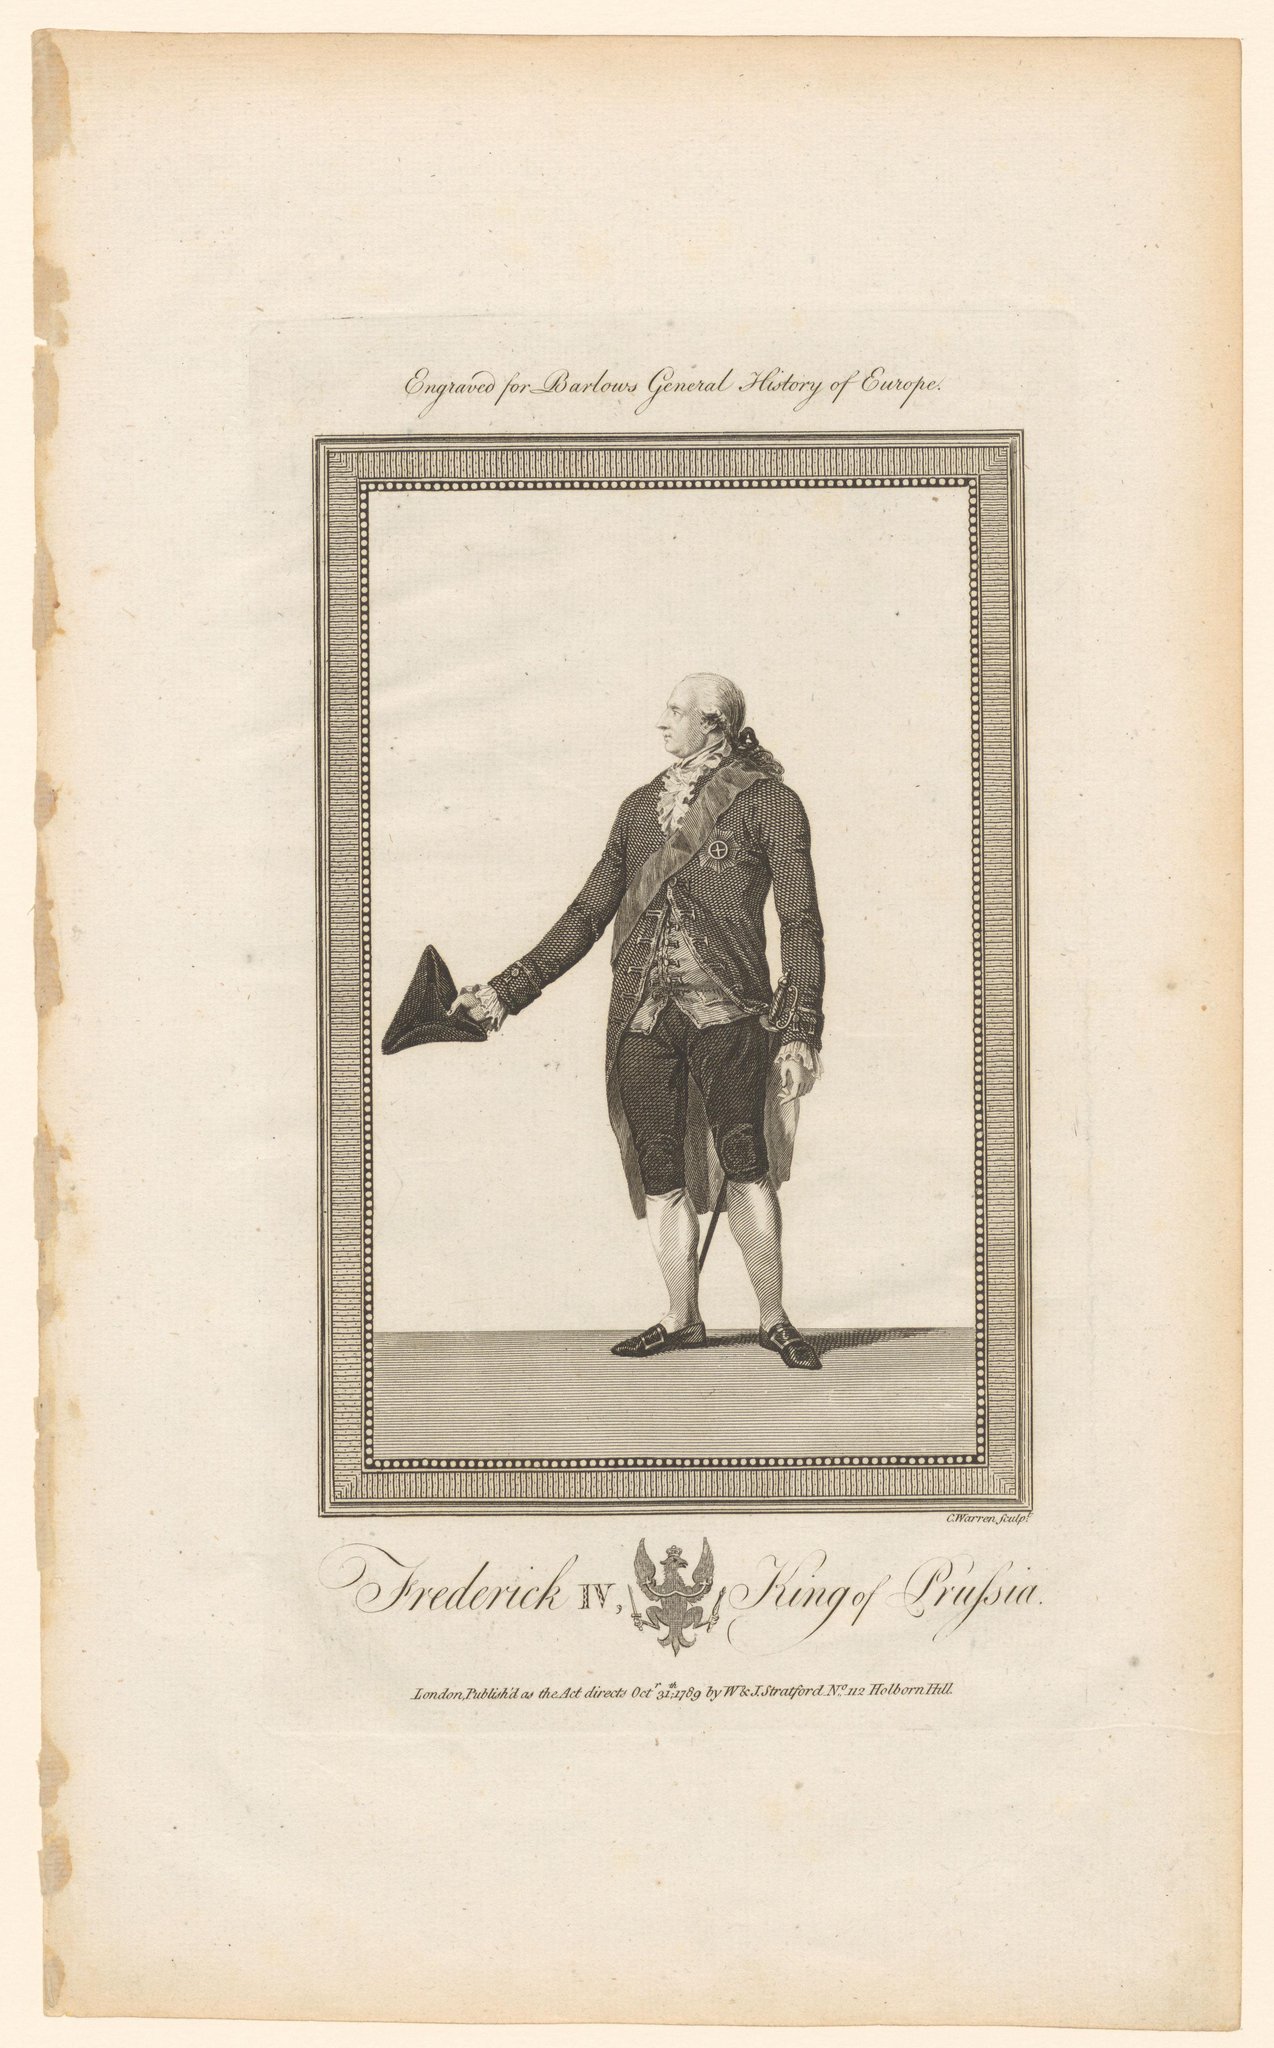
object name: print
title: Portret van Frederik de Grote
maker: charles turner warren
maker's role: print maker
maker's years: 1762-1823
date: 1789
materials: paper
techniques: engraving, etching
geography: london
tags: berlin, frederick ii (king of prussia), historical persons, king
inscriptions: collector's mark: Lugt 2228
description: Prent is mogelijk gebruikt in: Barlow, Percival. The General History of Europe (...). Londen: William & James Stratford, 1789.